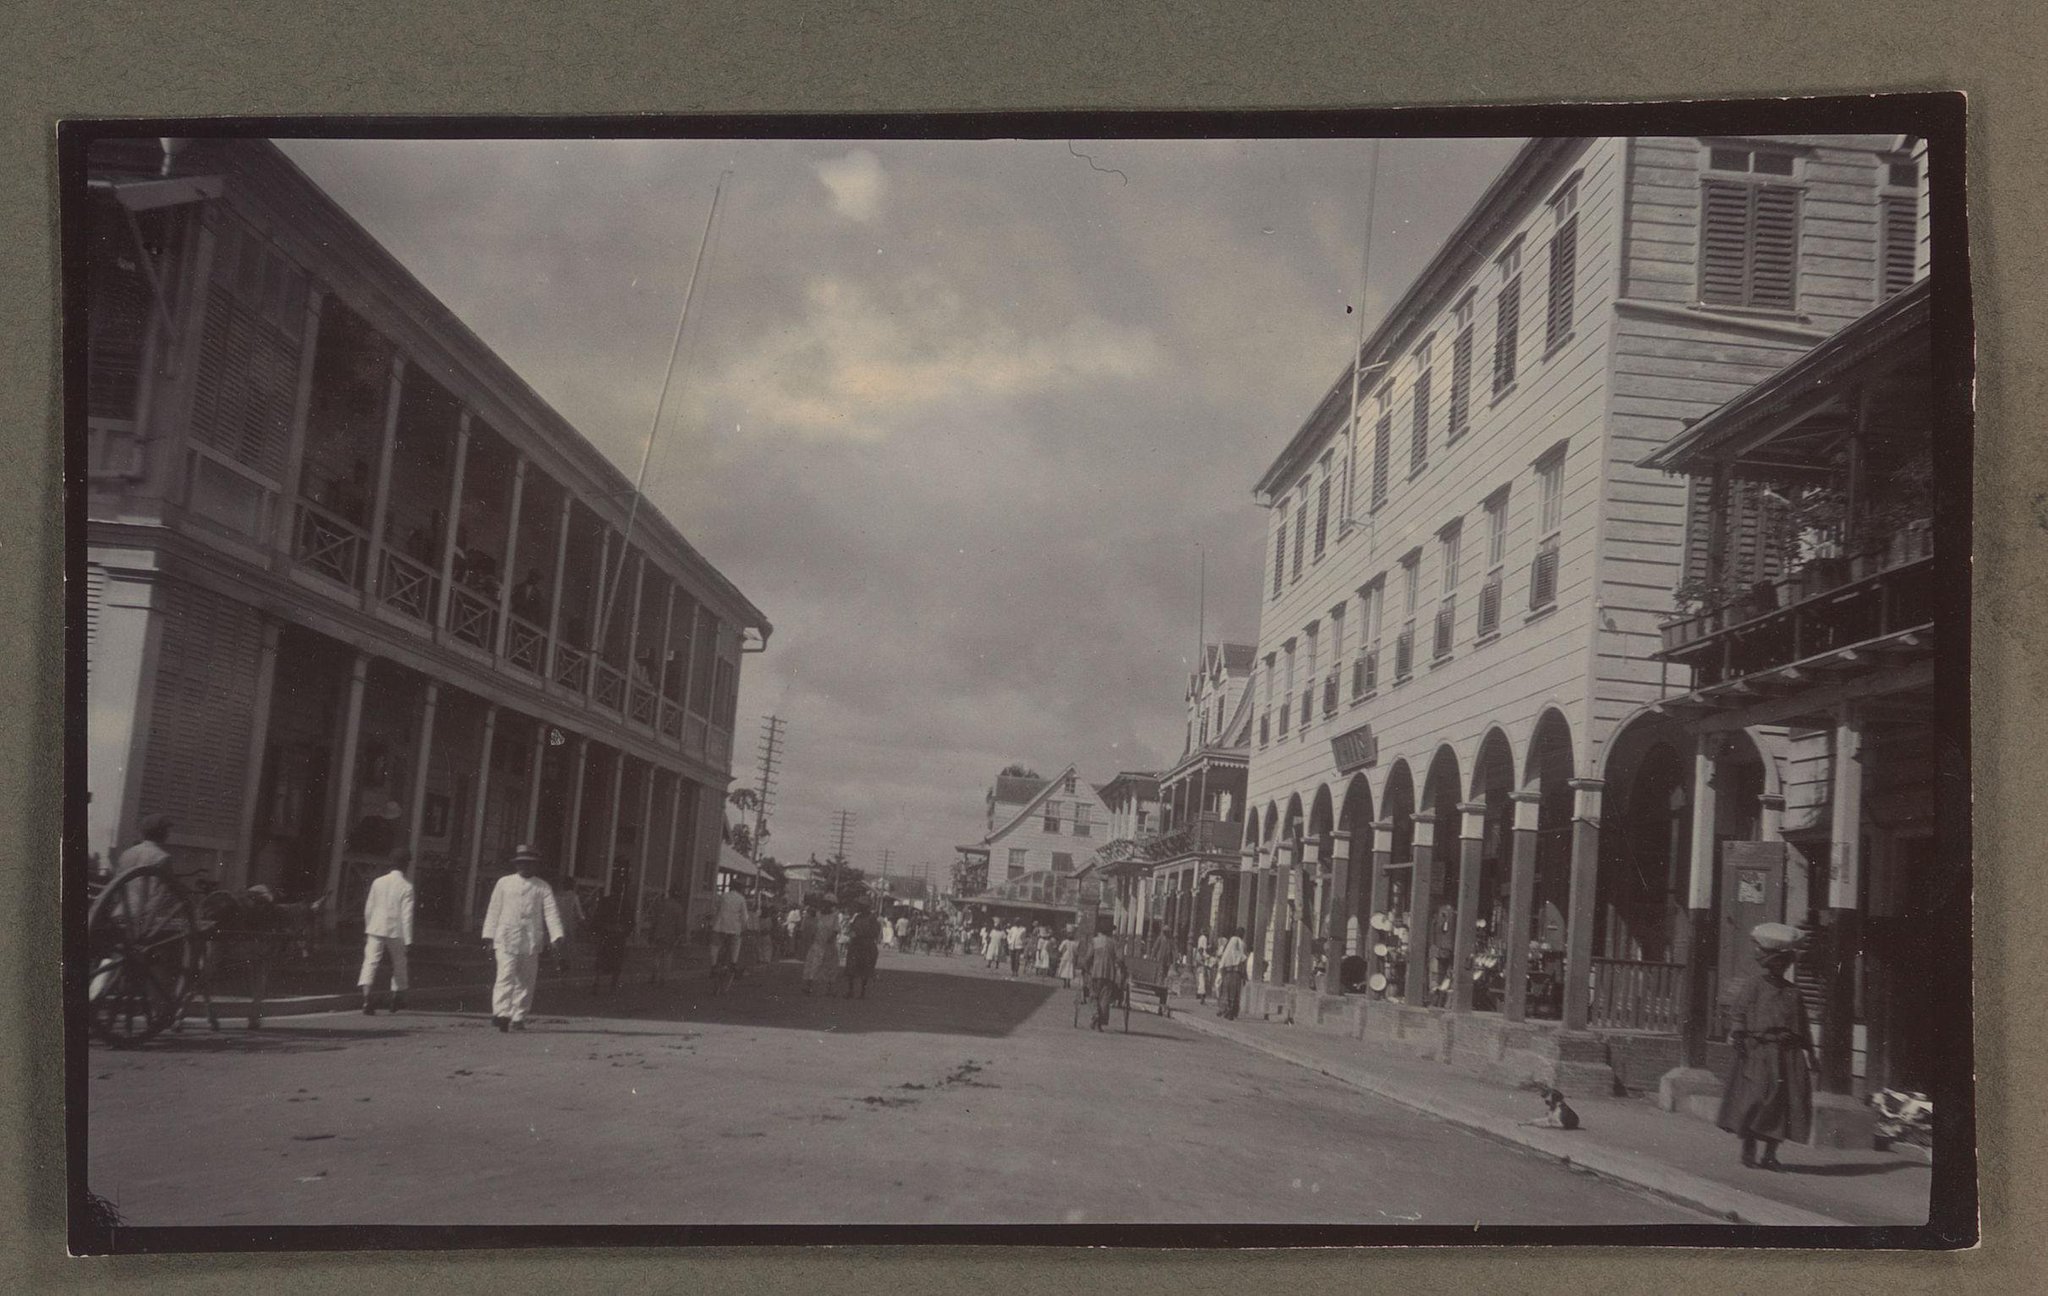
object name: photograph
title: Straat in Paramaribo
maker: Anonymous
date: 1925-1927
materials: photographic support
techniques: photography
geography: suriname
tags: jetten, familie, moengo, paramaribo (stad)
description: Straat in Paramaribo. Foto op een bladzijde van een los albumblad. Onderdeel van het ensemble met foto's van de familie van ingenieur Jetten in de mijnbouwstad Moengo in Suriname.